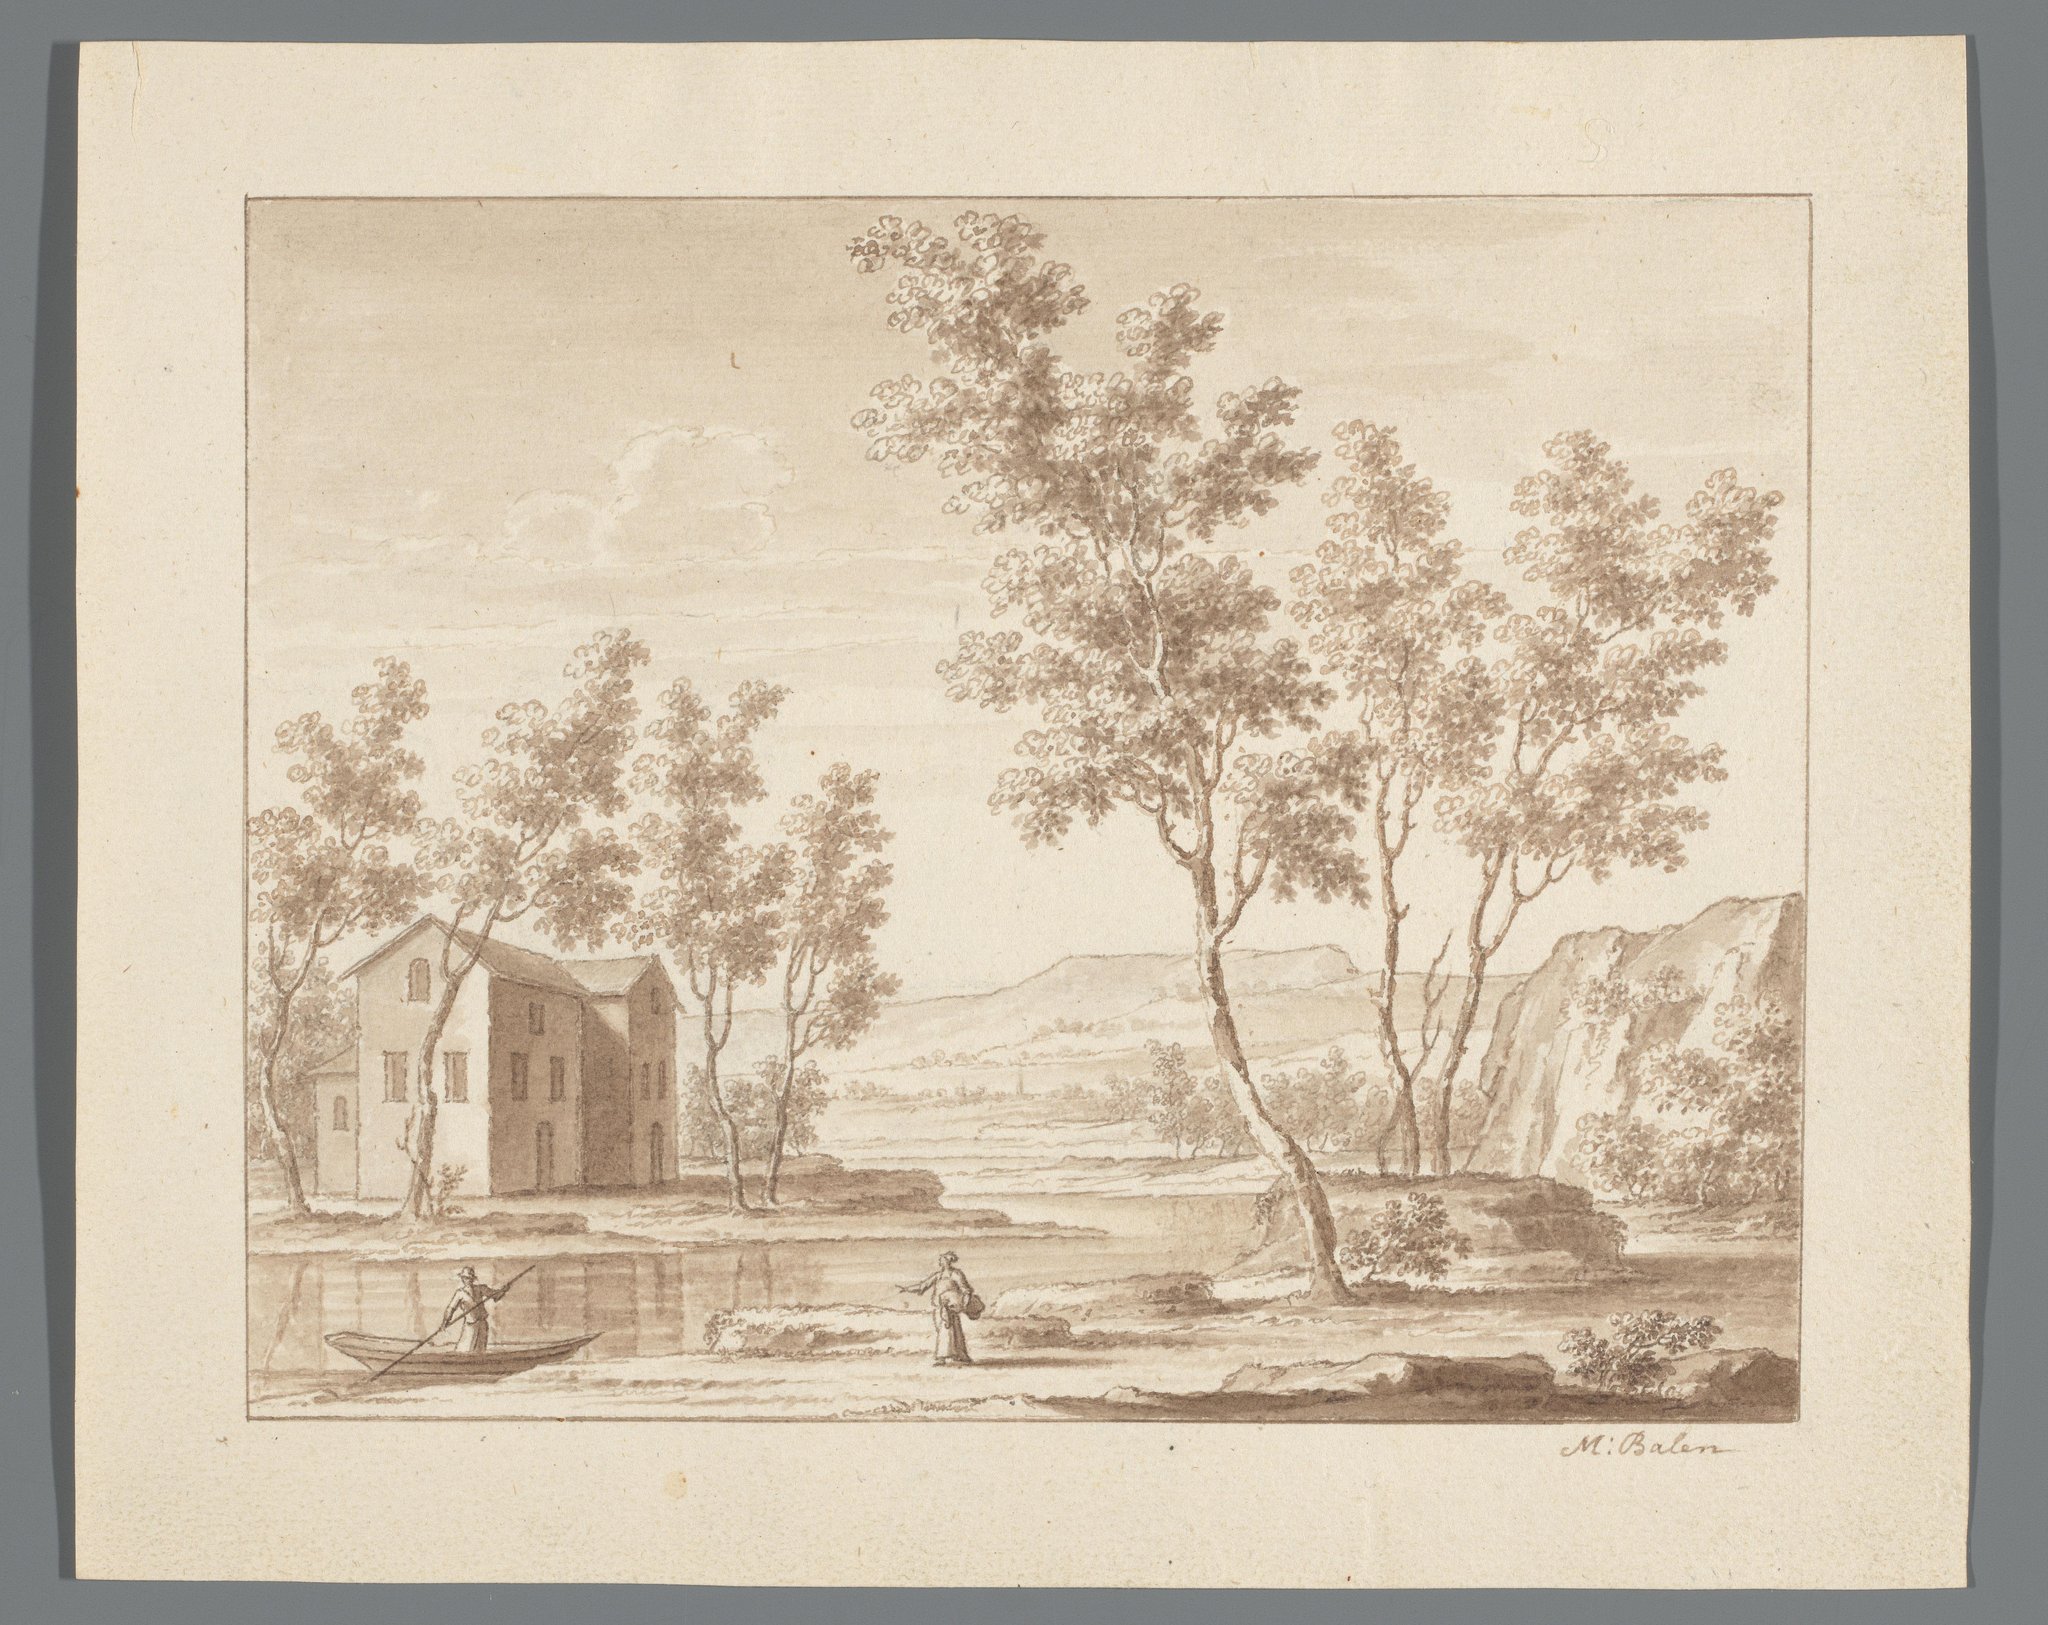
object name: drawing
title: Rivierlandschap met gebouw, een bootje en twee figuren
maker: matthijs balen (1684-1766)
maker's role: draughtsman, painter, print maker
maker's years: 1684-1766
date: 1694-1766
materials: paper, pencil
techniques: brush, pen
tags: city-view, and landscape with man-made constructions, rural housing, e.g. country-house, villa, cottage, rowing-boat, canoe, etc.